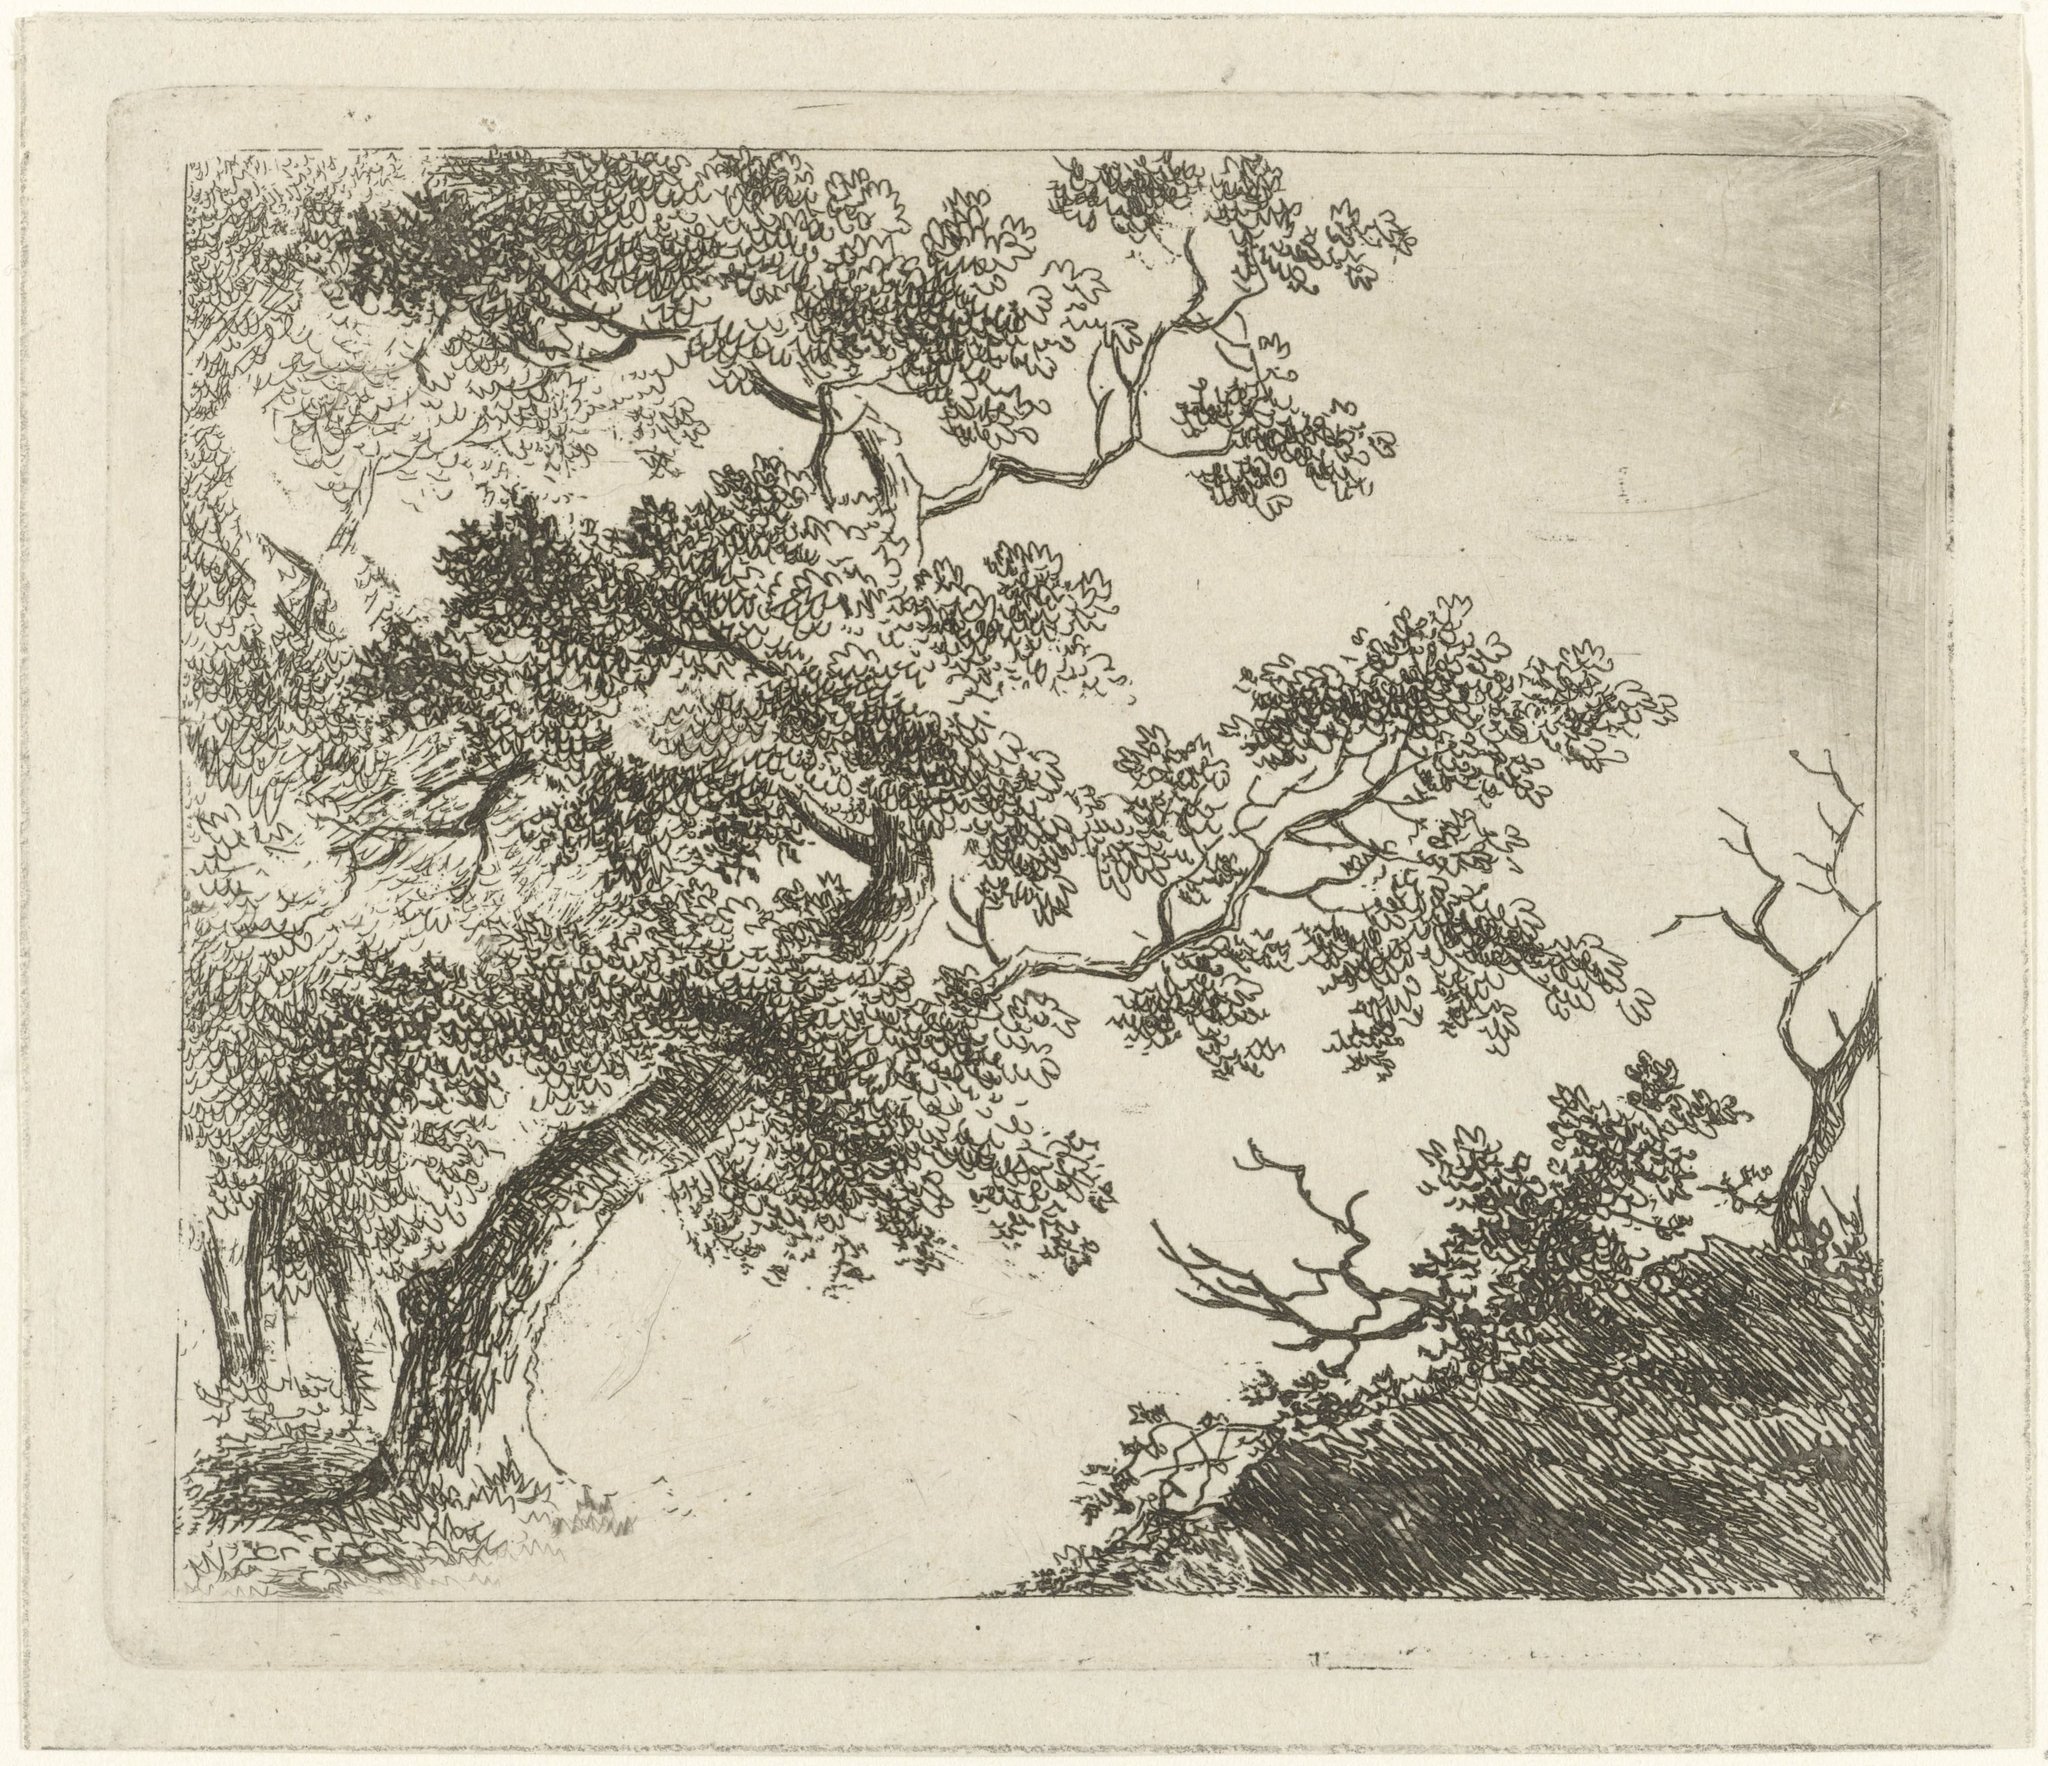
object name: print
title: Boslandschap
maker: johannes janson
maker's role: draughtsman, painter, print maker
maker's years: 1729-1784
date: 1761-1784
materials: paper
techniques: etching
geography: leiden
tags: forest, wood (+ landscape with figures, staffage)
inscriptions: collector's mark: Lugt 240